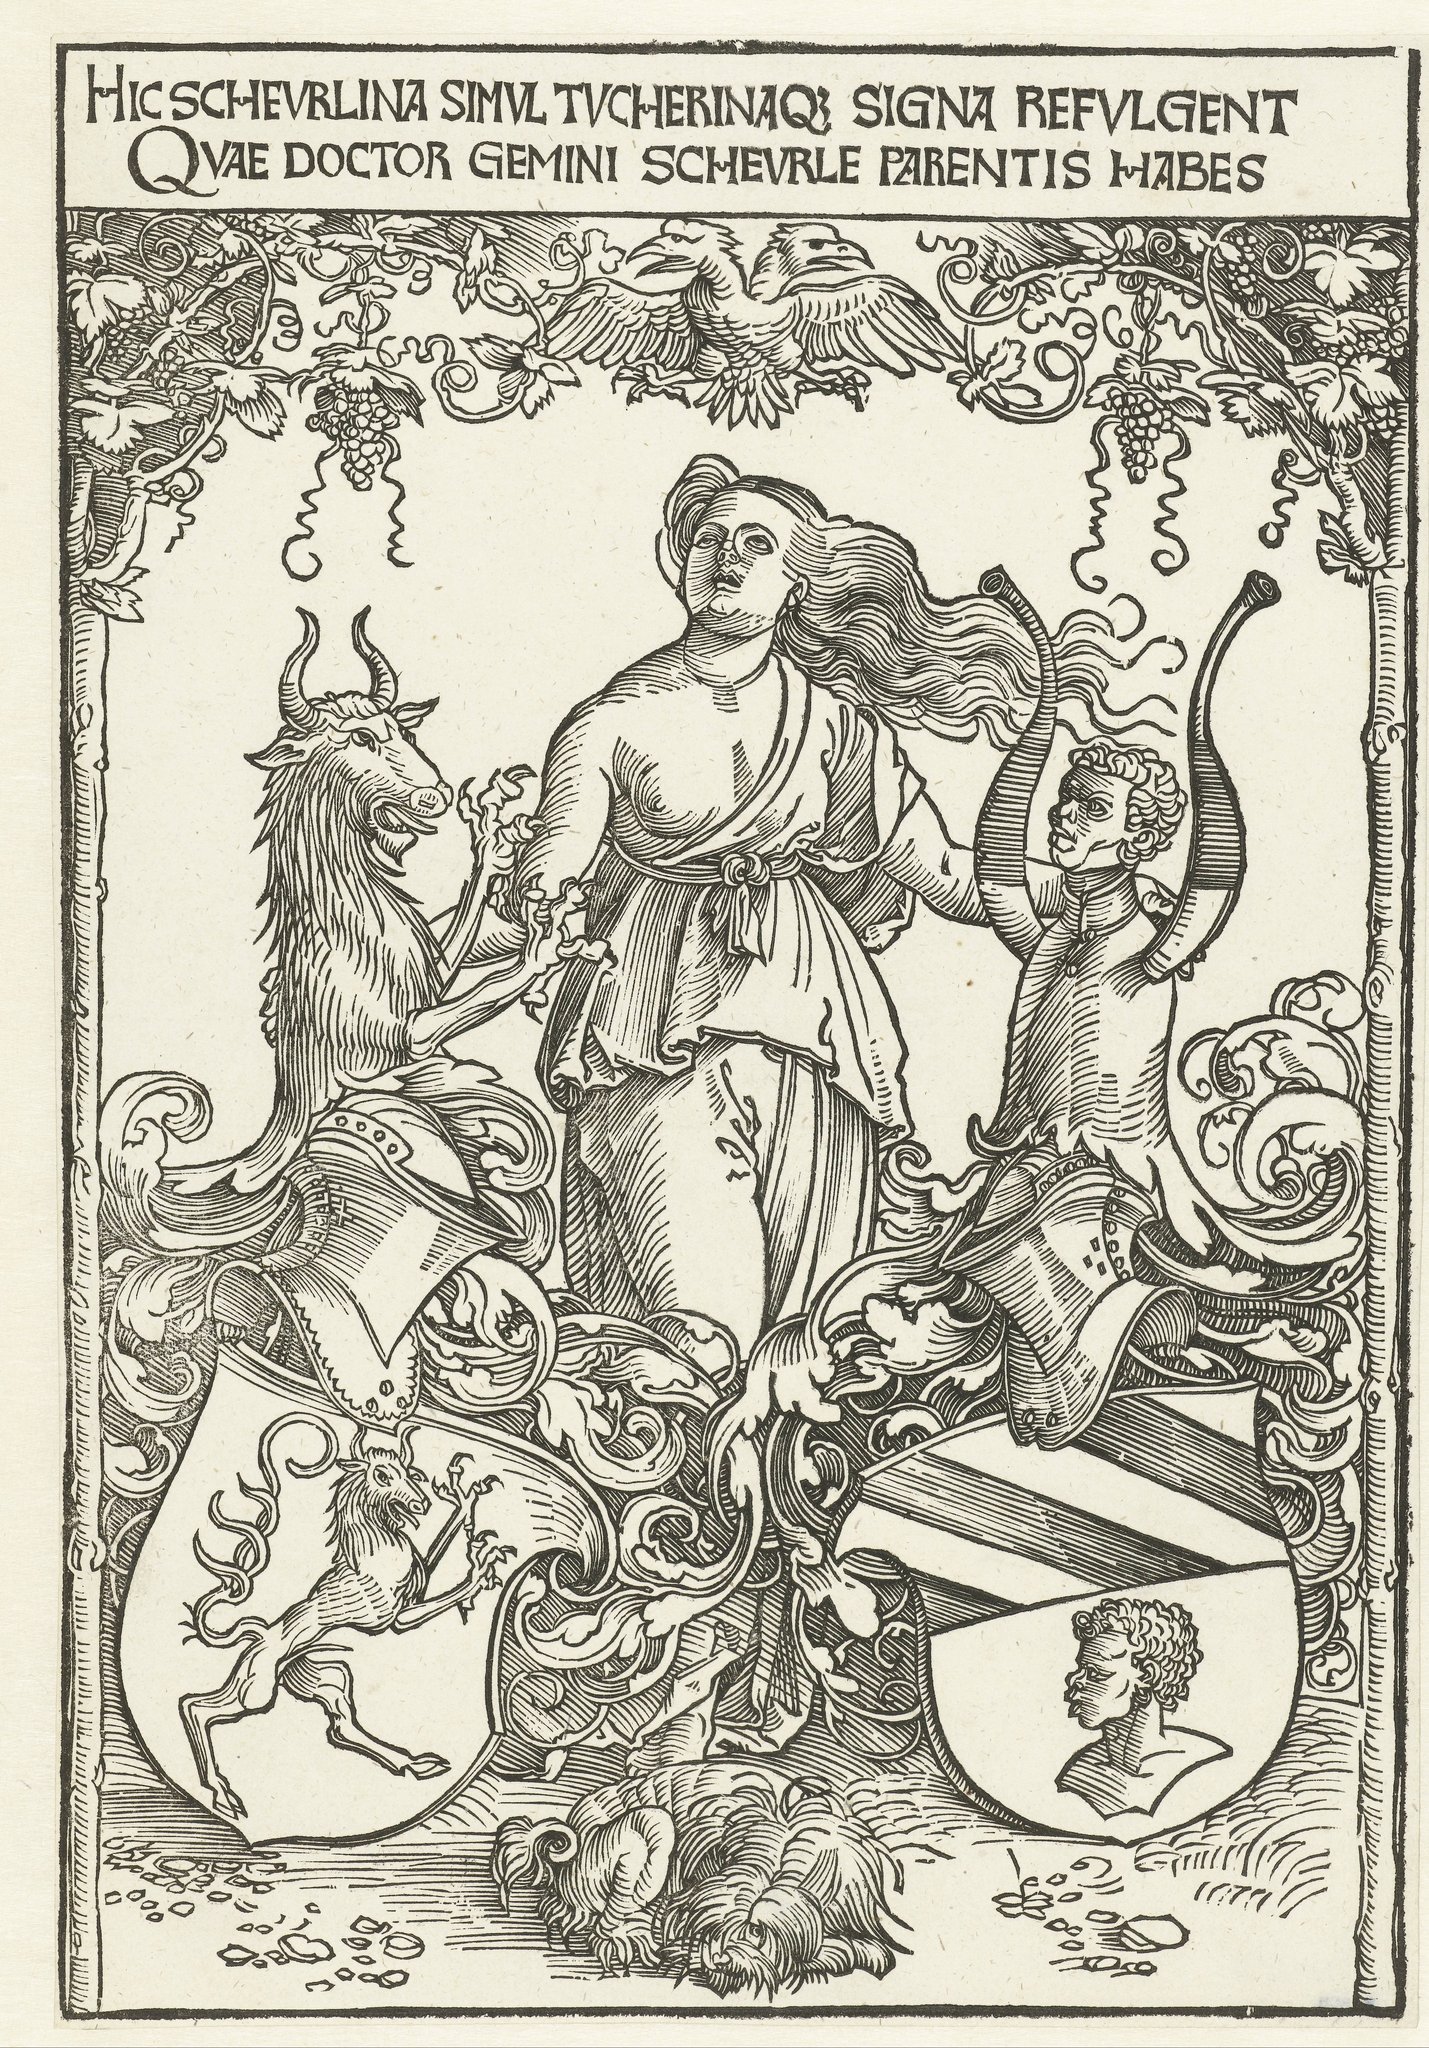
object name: print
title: Wapens van de families Scheurl en Tucher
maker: albrecht dürer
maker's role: draughtsman, painter, print maker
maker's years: 1471-1528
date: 1512-1520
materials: paper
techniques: woodcut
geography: nuremberg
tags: armorial bearing, heraldry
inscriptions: collector's mark: Lugt 2228, collector's mark: ‘M. SCH.’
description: Wapens van de ouders van Christoph Scheurl (Christoph Scheurl en Helena Tucher geheten), bijeengehouden door een jongedame met wapperende haren. Op de voorgrond een hondje. Boven de voorstelling twee regels tekst in het Latijn.